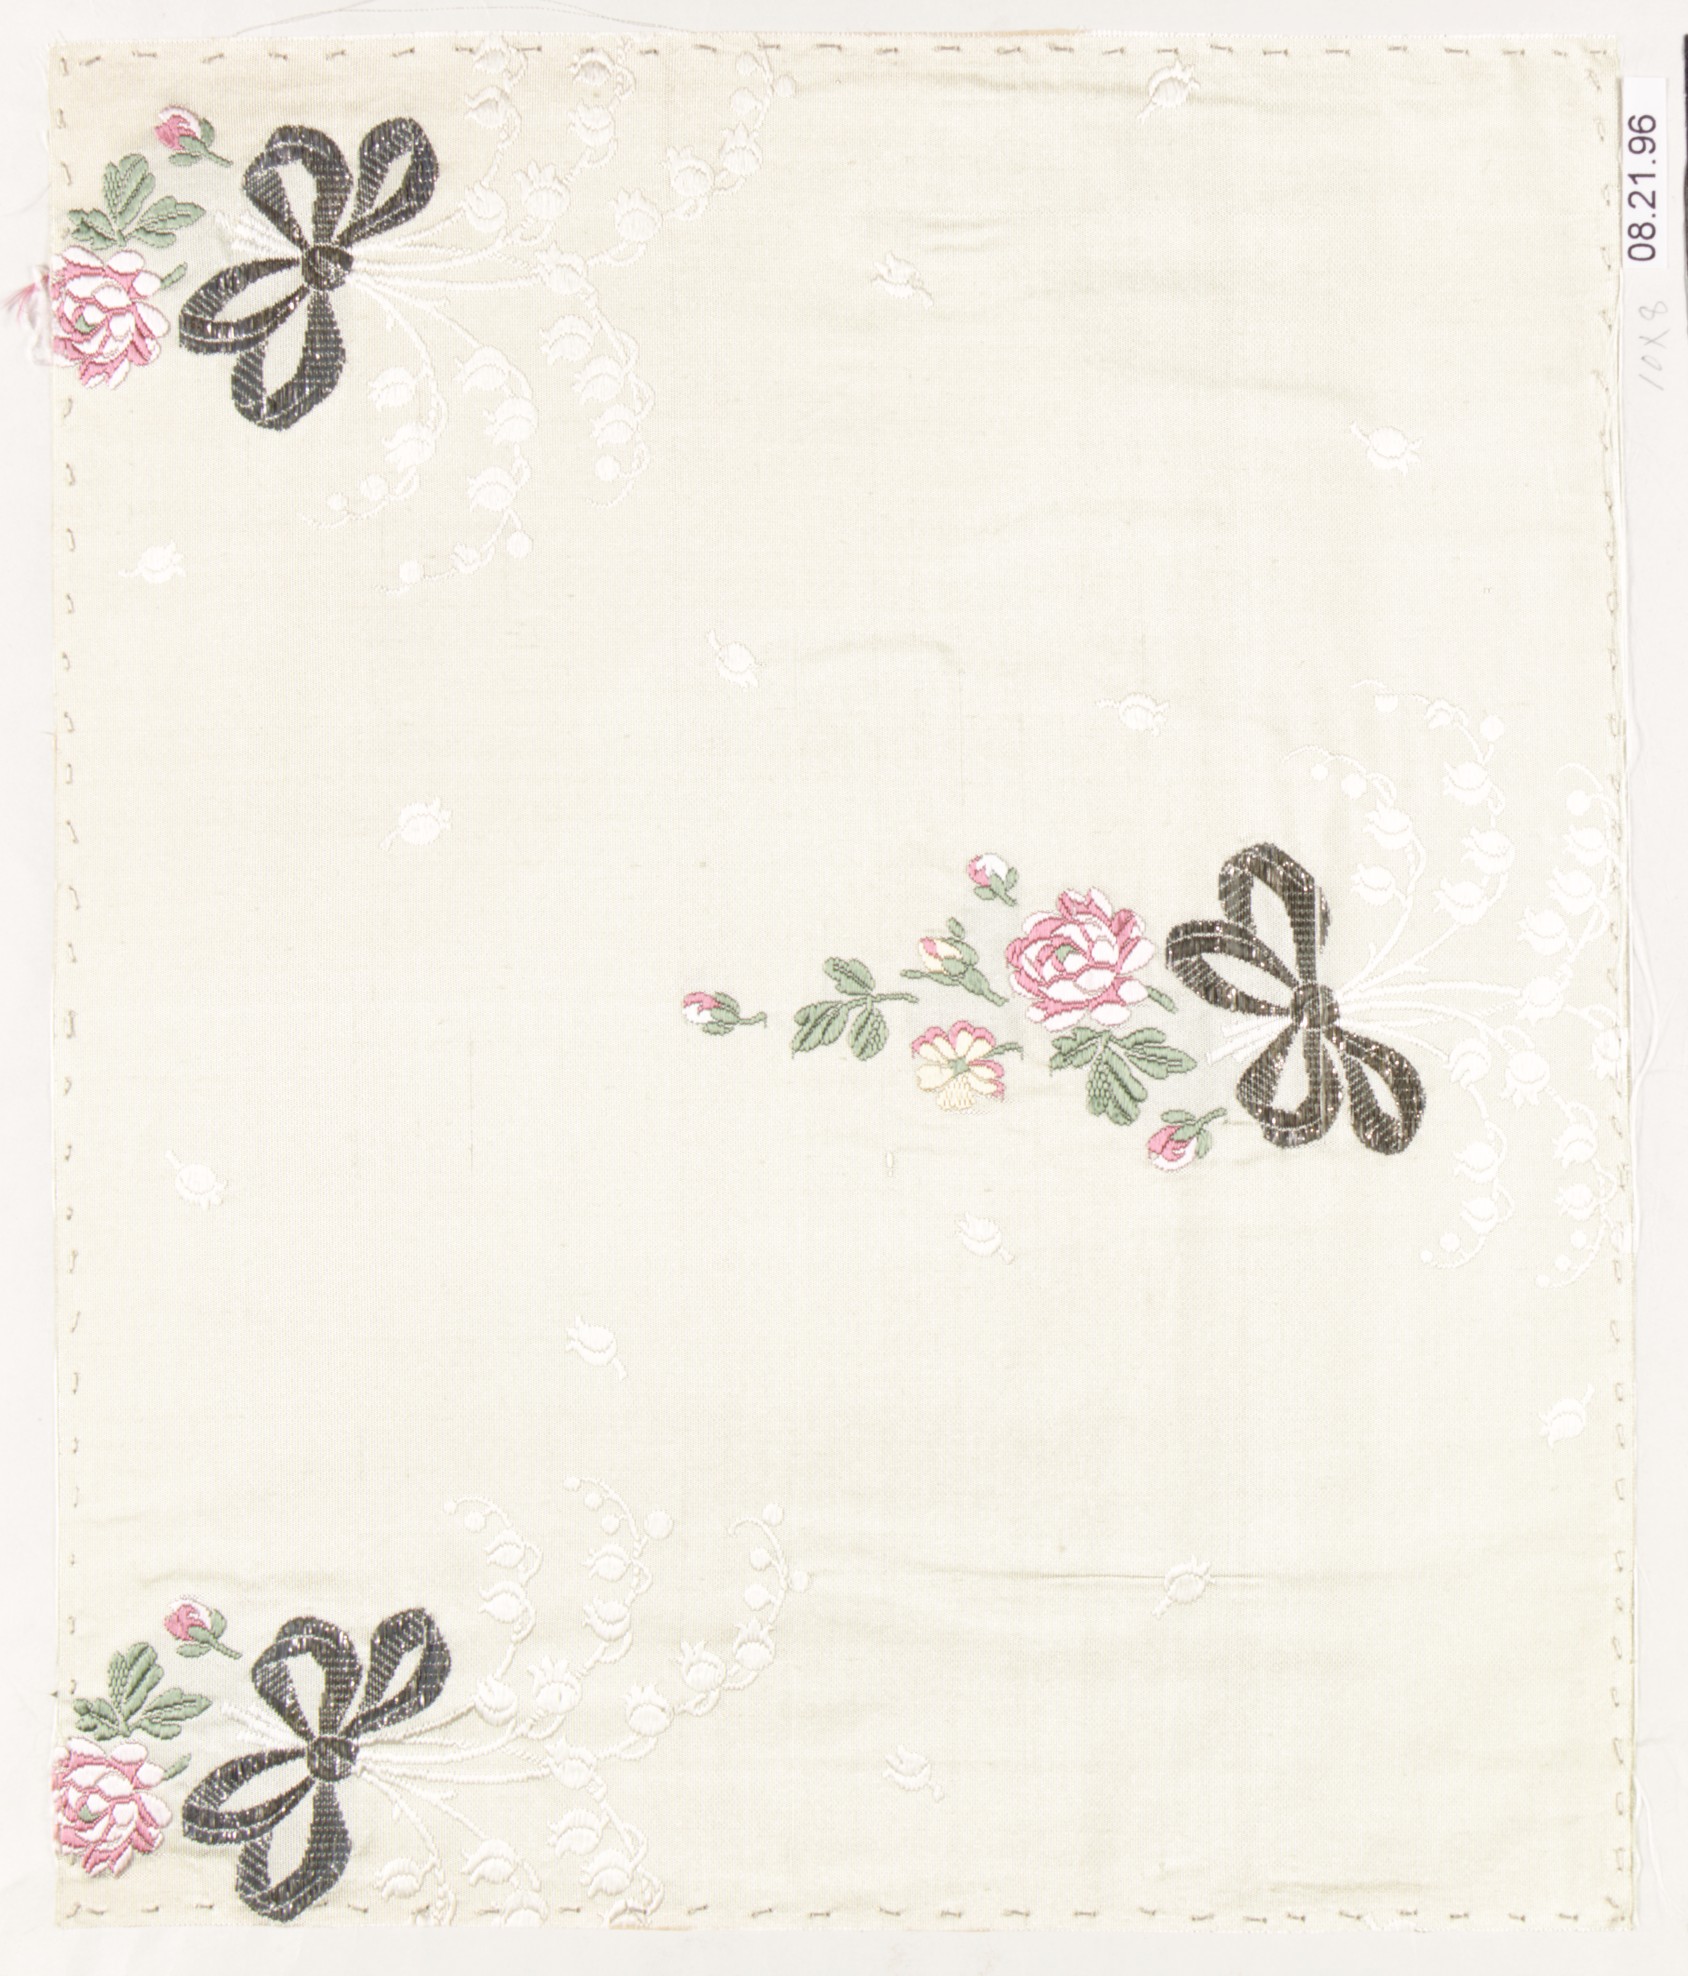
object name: textile sample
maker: Anonymous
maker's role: designer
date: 1900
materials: silk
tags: flowers